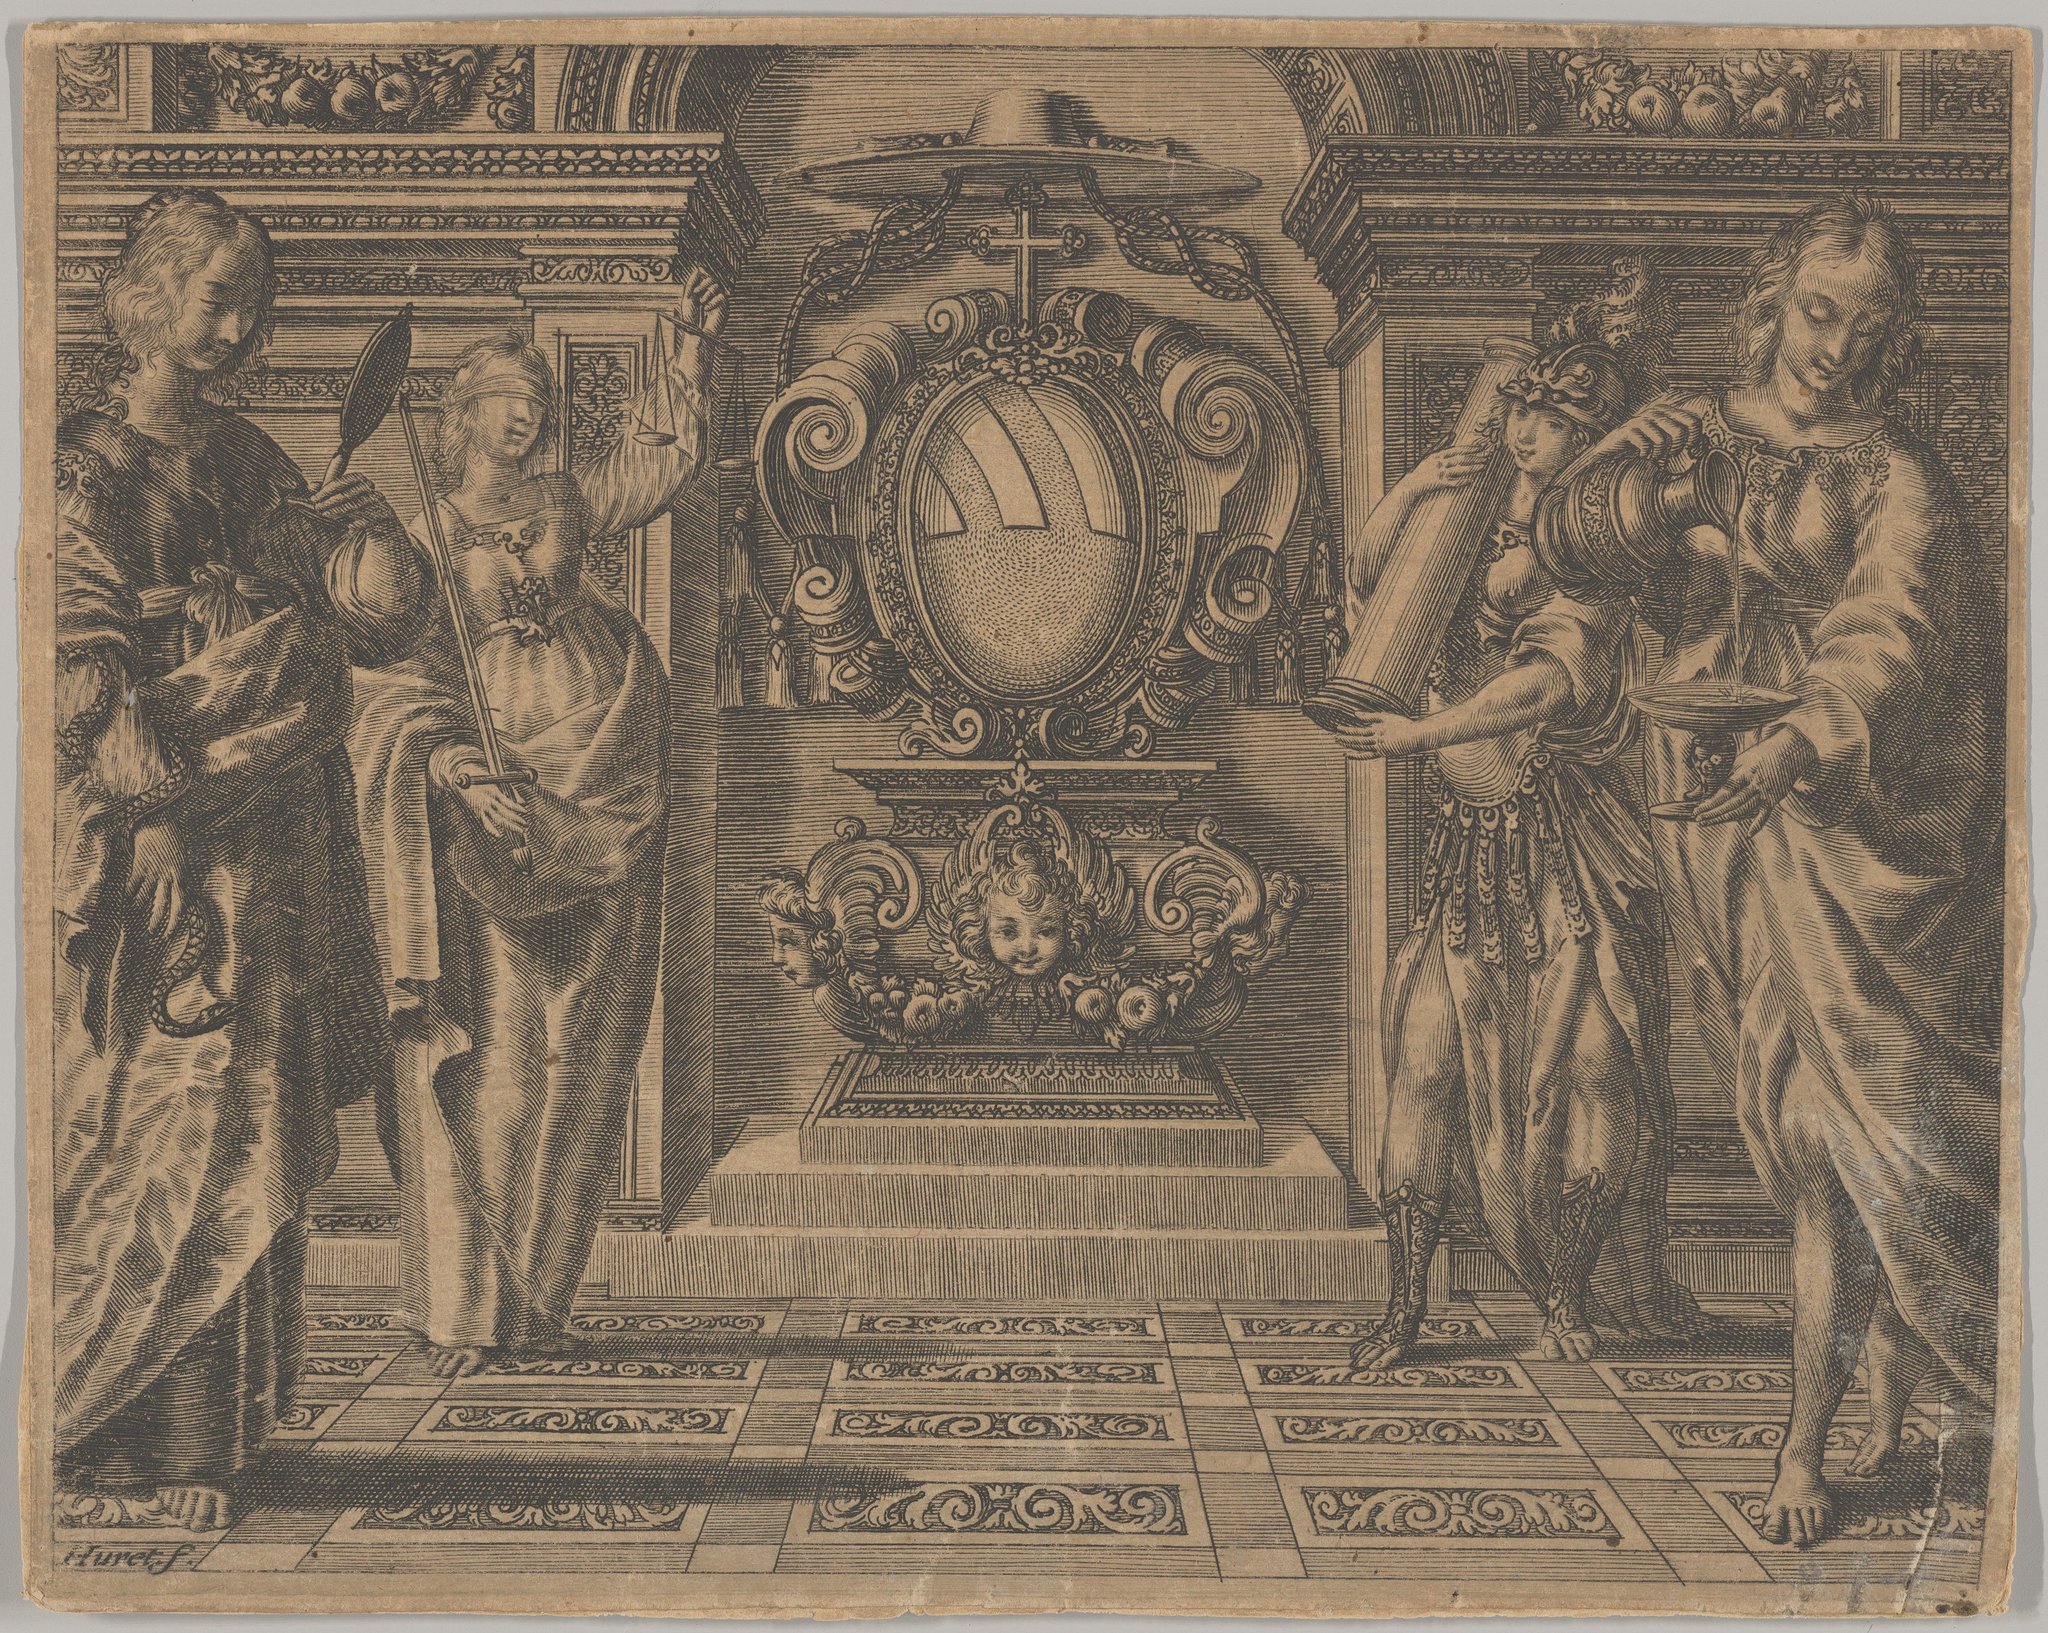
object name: print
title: Arms of the Ludovisi Family Surrounded by Four Allegorical Figures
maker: jean couvay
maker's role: artist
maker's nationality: french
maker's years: 1600-1663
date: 1601-1700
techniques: engraving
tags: women,coat of arms